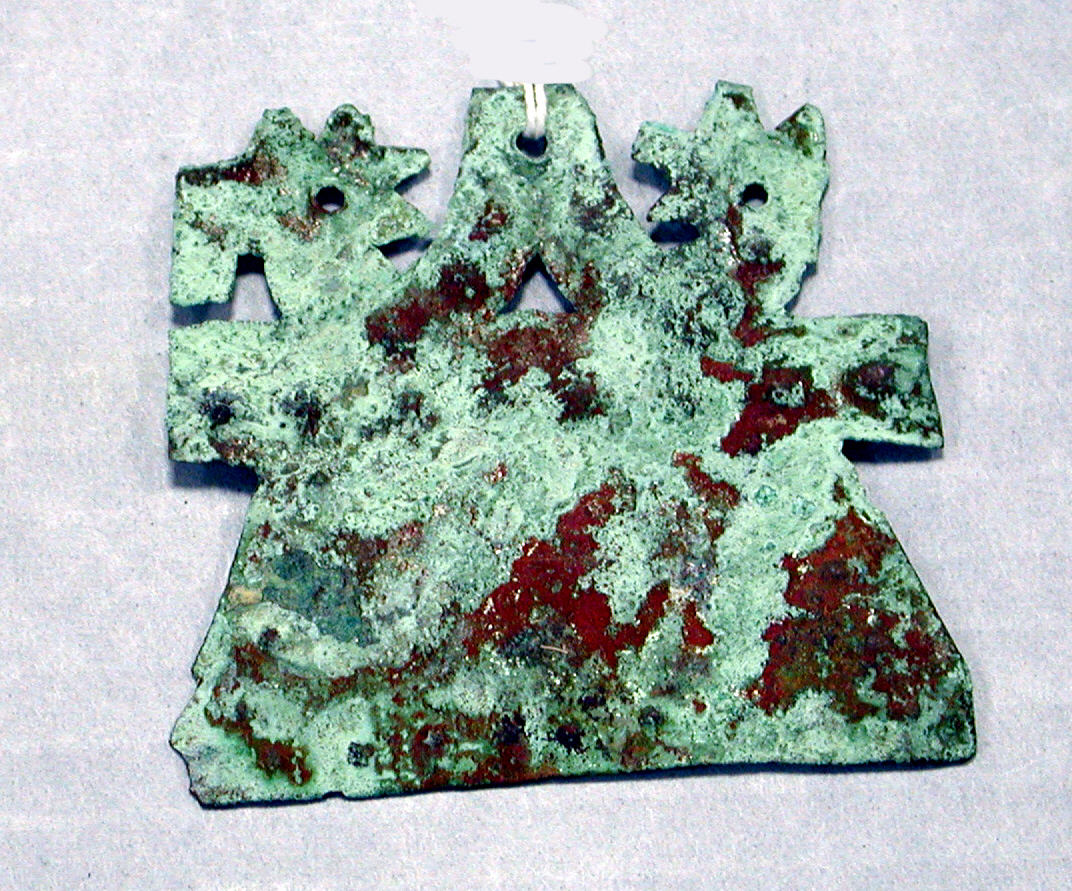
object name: ornament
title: Copper Poncho Ornament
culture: chimú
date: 1101-1500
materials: copper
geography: peru